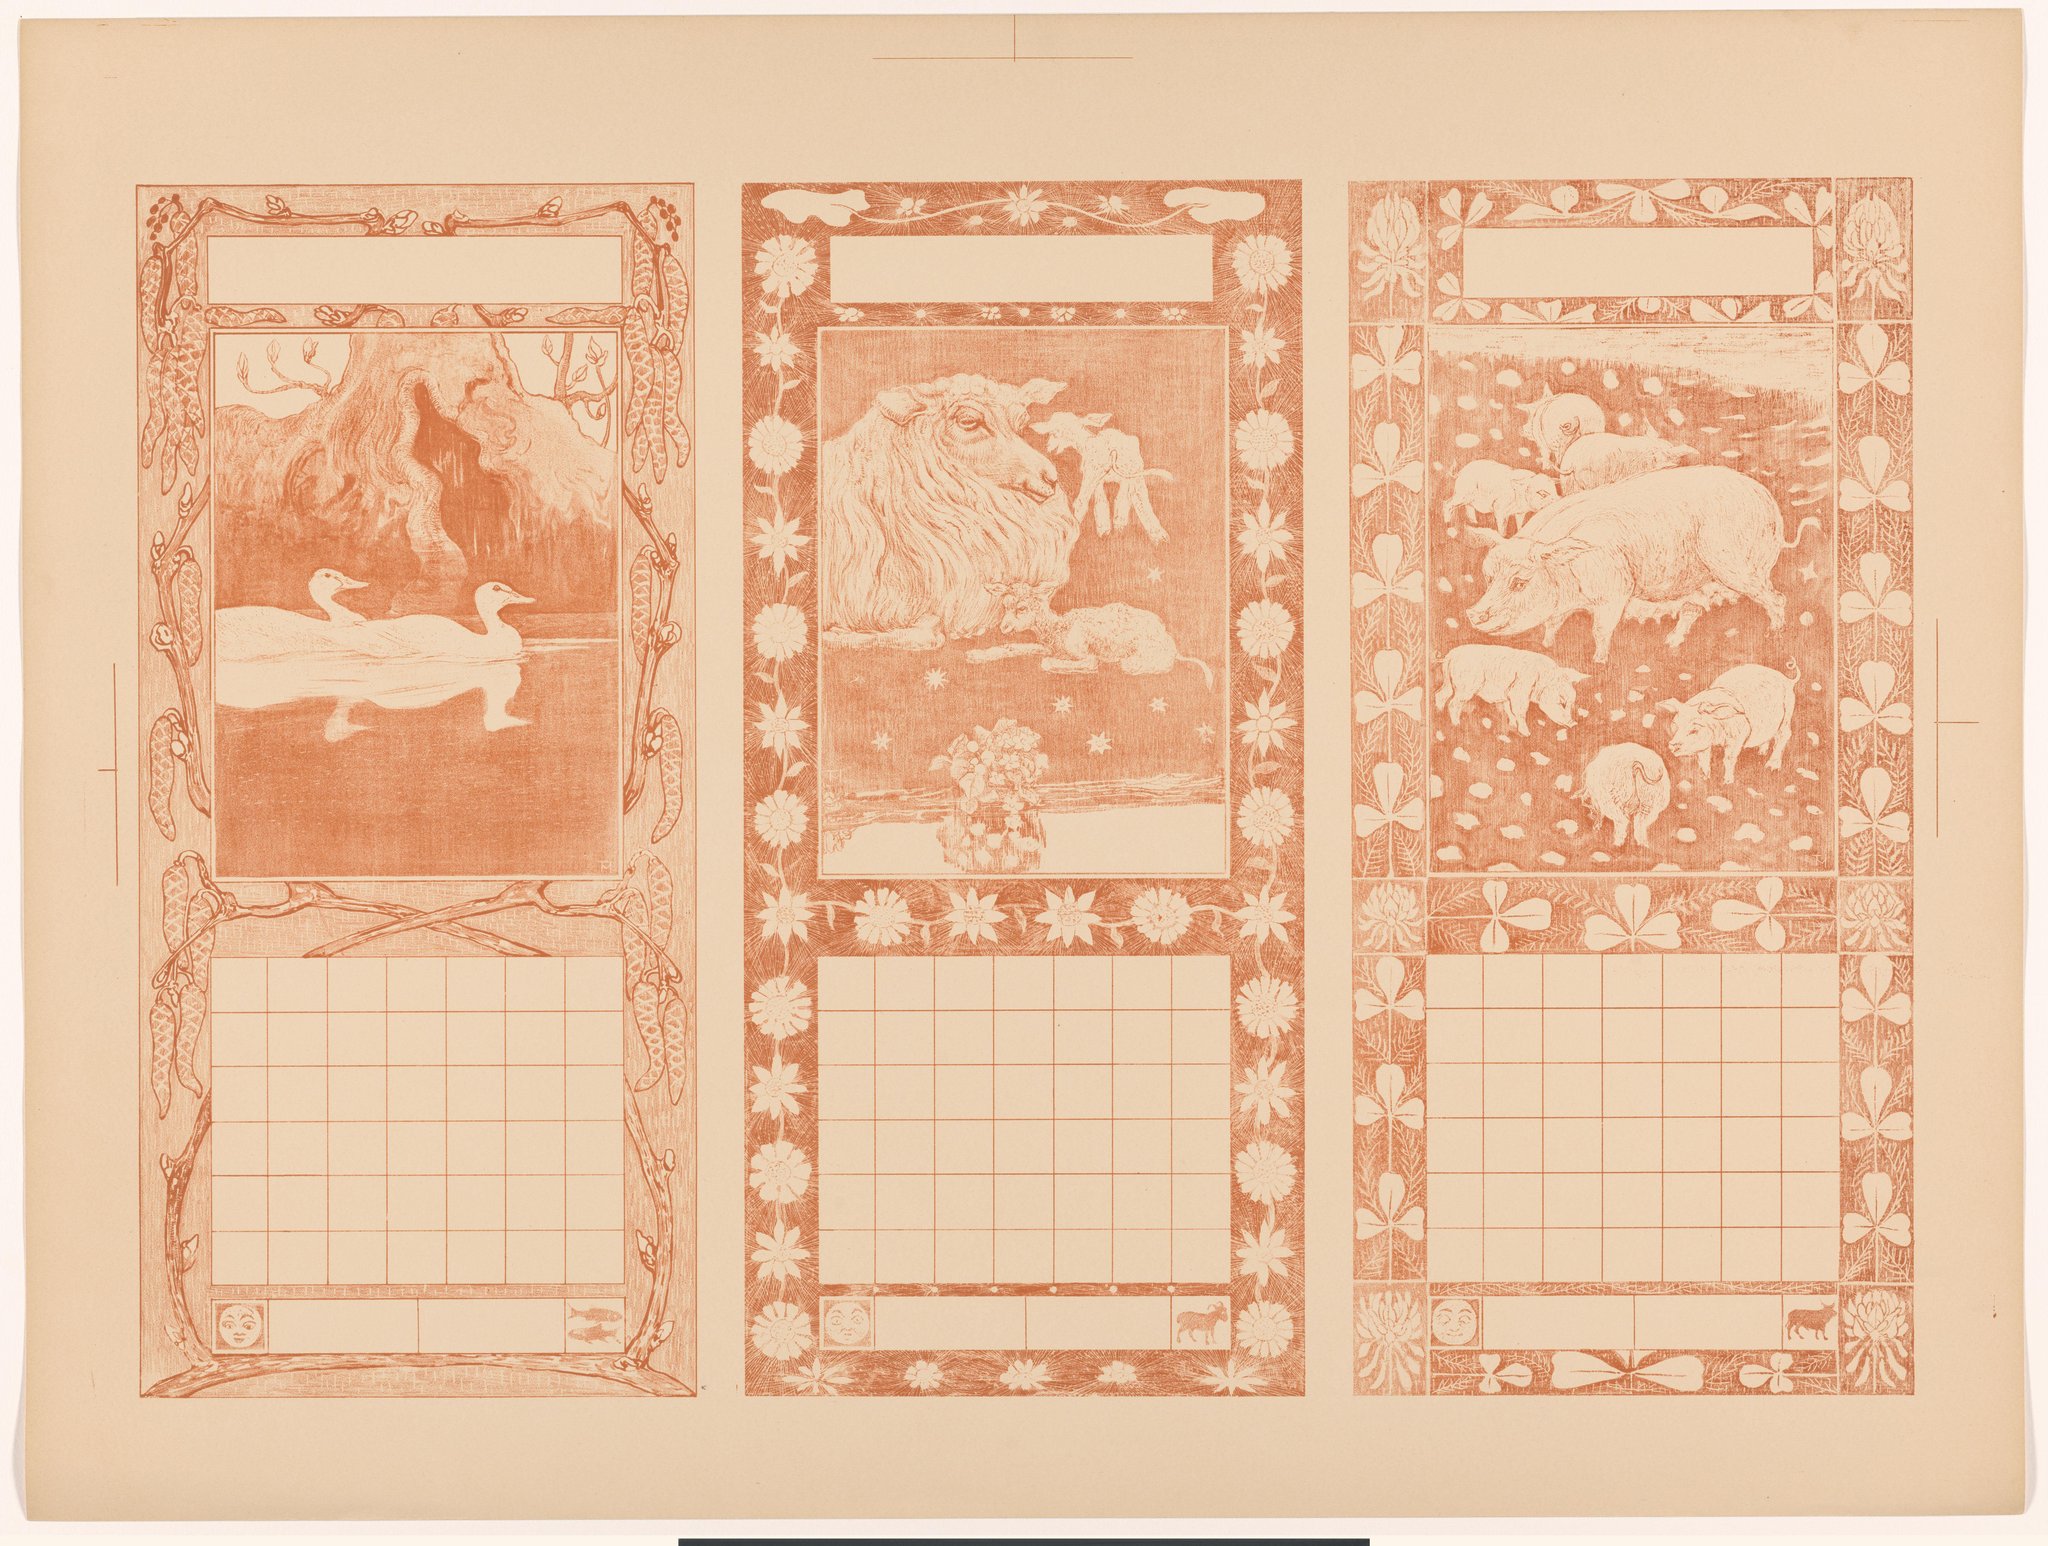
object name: print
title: Kalenders voor februari, maart en april 1904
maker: theo van hoytema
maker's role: draughtsman, painter, print maker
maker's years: 1863-1917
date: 1904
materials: paper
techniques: lithograph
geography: amsterdam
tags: pig, calendar, almanac, sheep, water-birds: duck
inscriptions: collector's mark: Lugt 2233